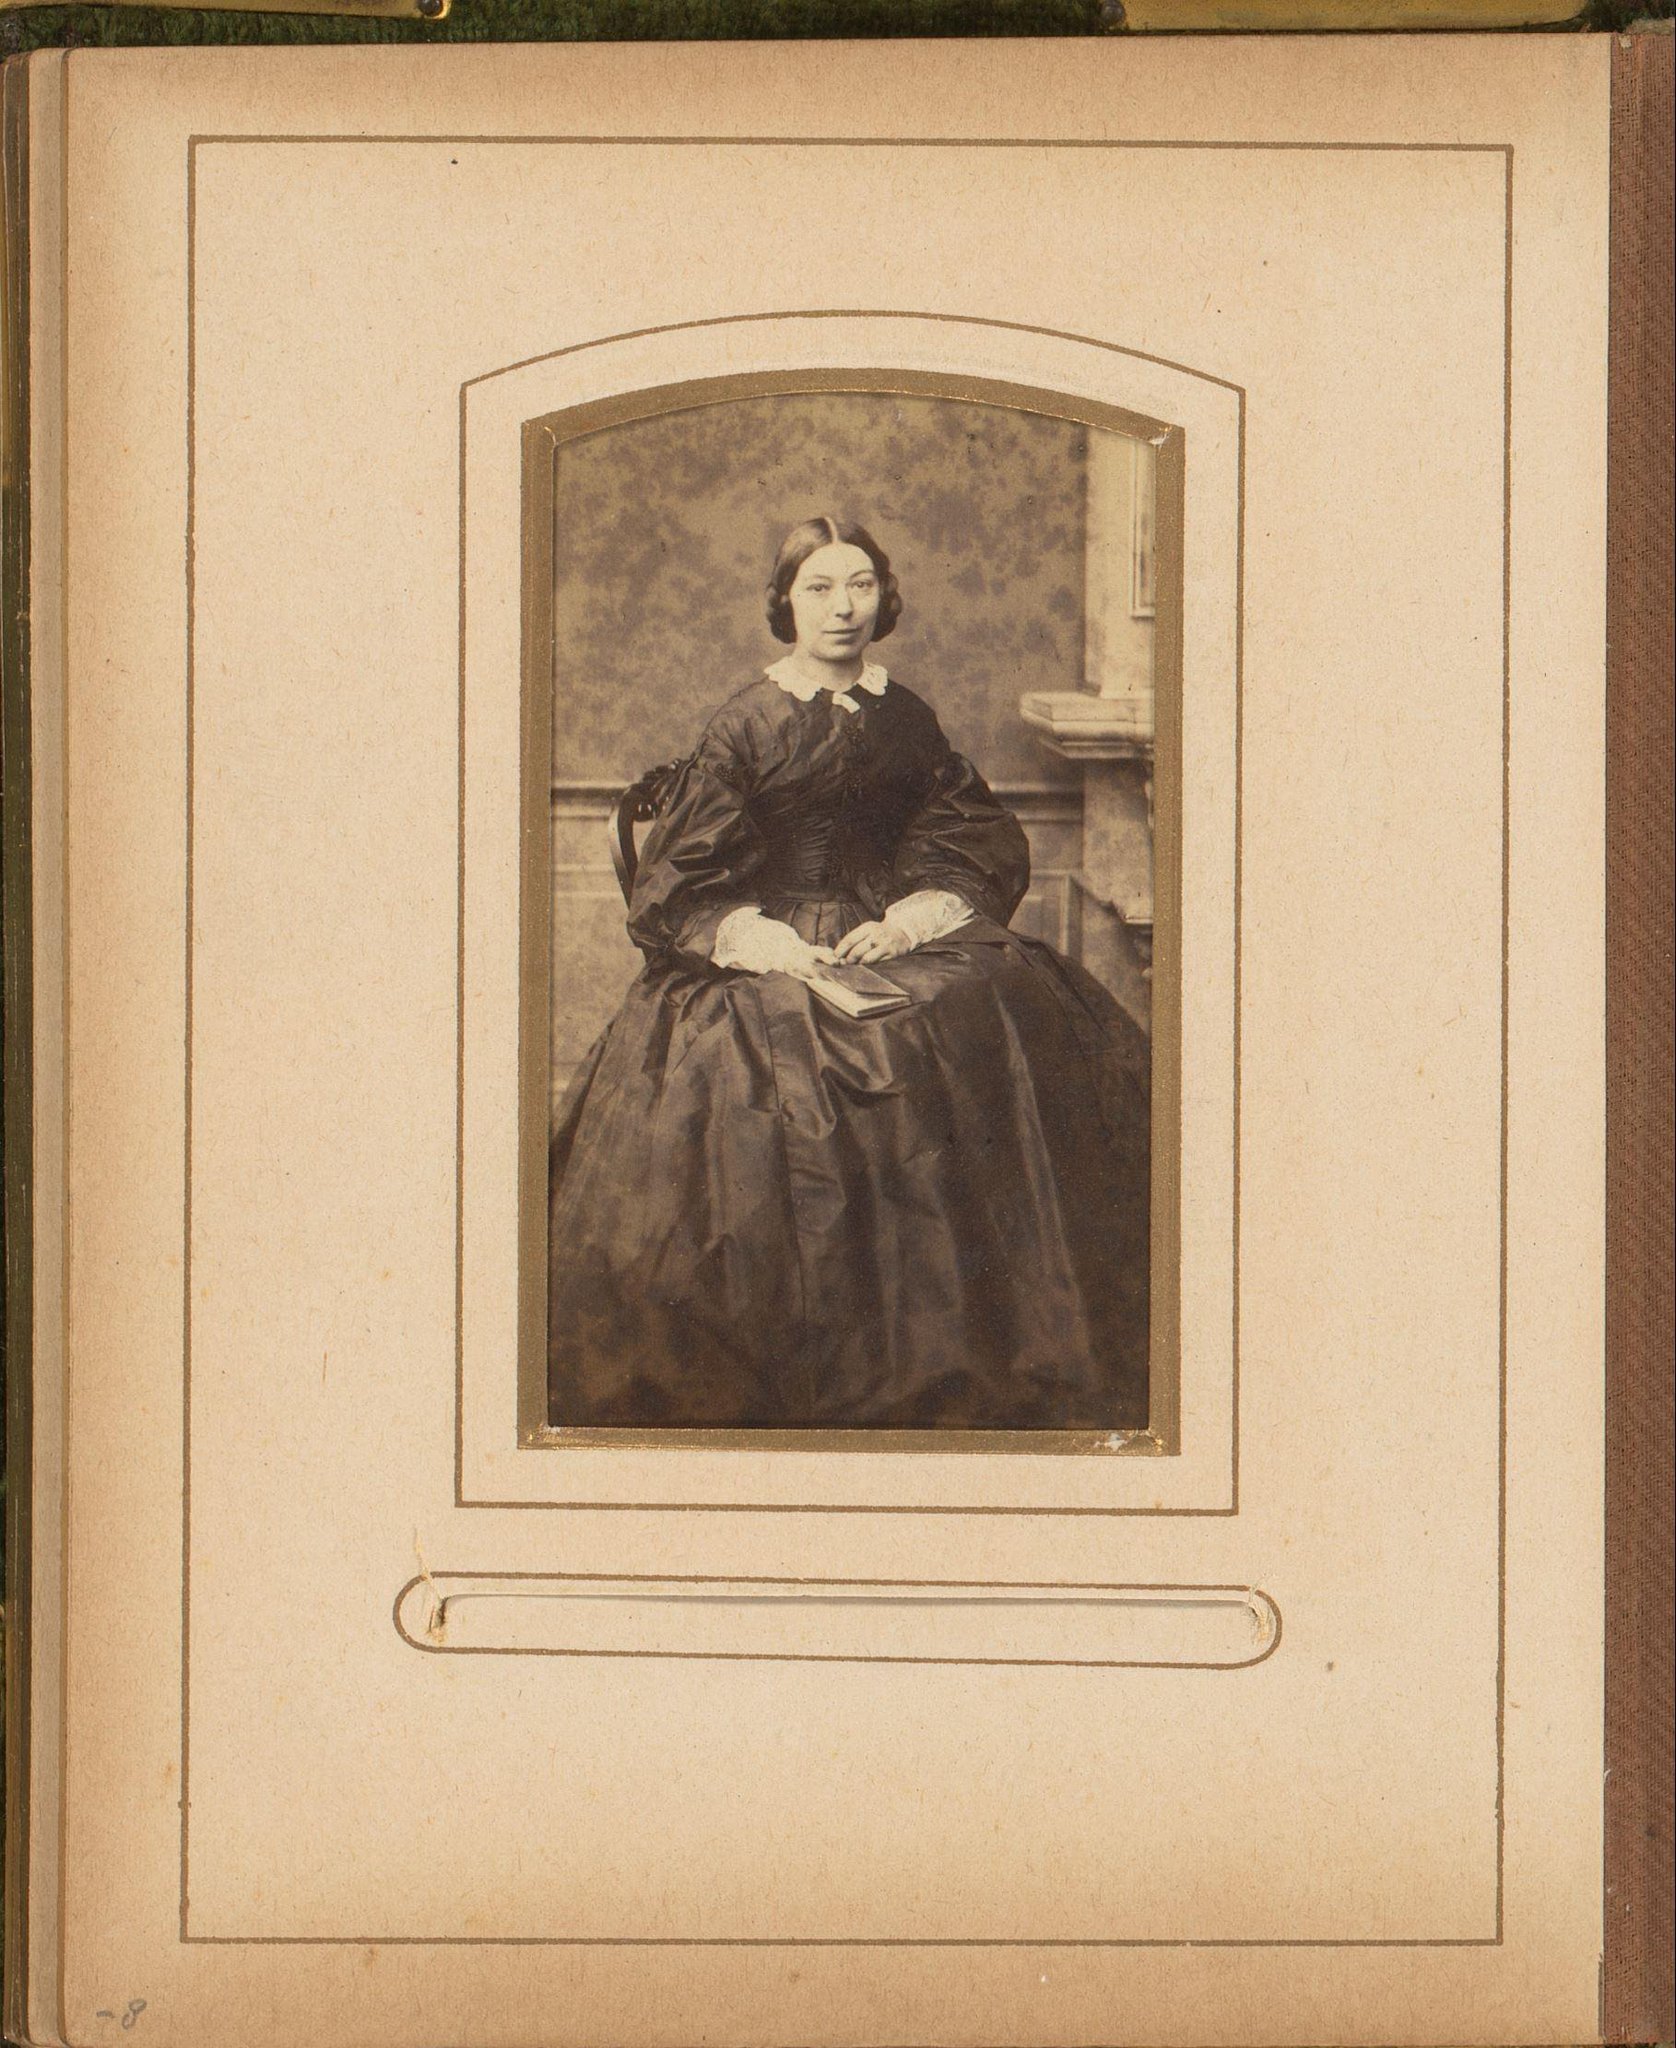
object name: photograph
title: Portret van een vrouw, mogelijk lid van de familie Beucker Andreae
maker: Anonymous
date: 1854-1885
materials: cardboard, paper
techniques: albumen print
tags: adult woman, anonymous historical person portrayed